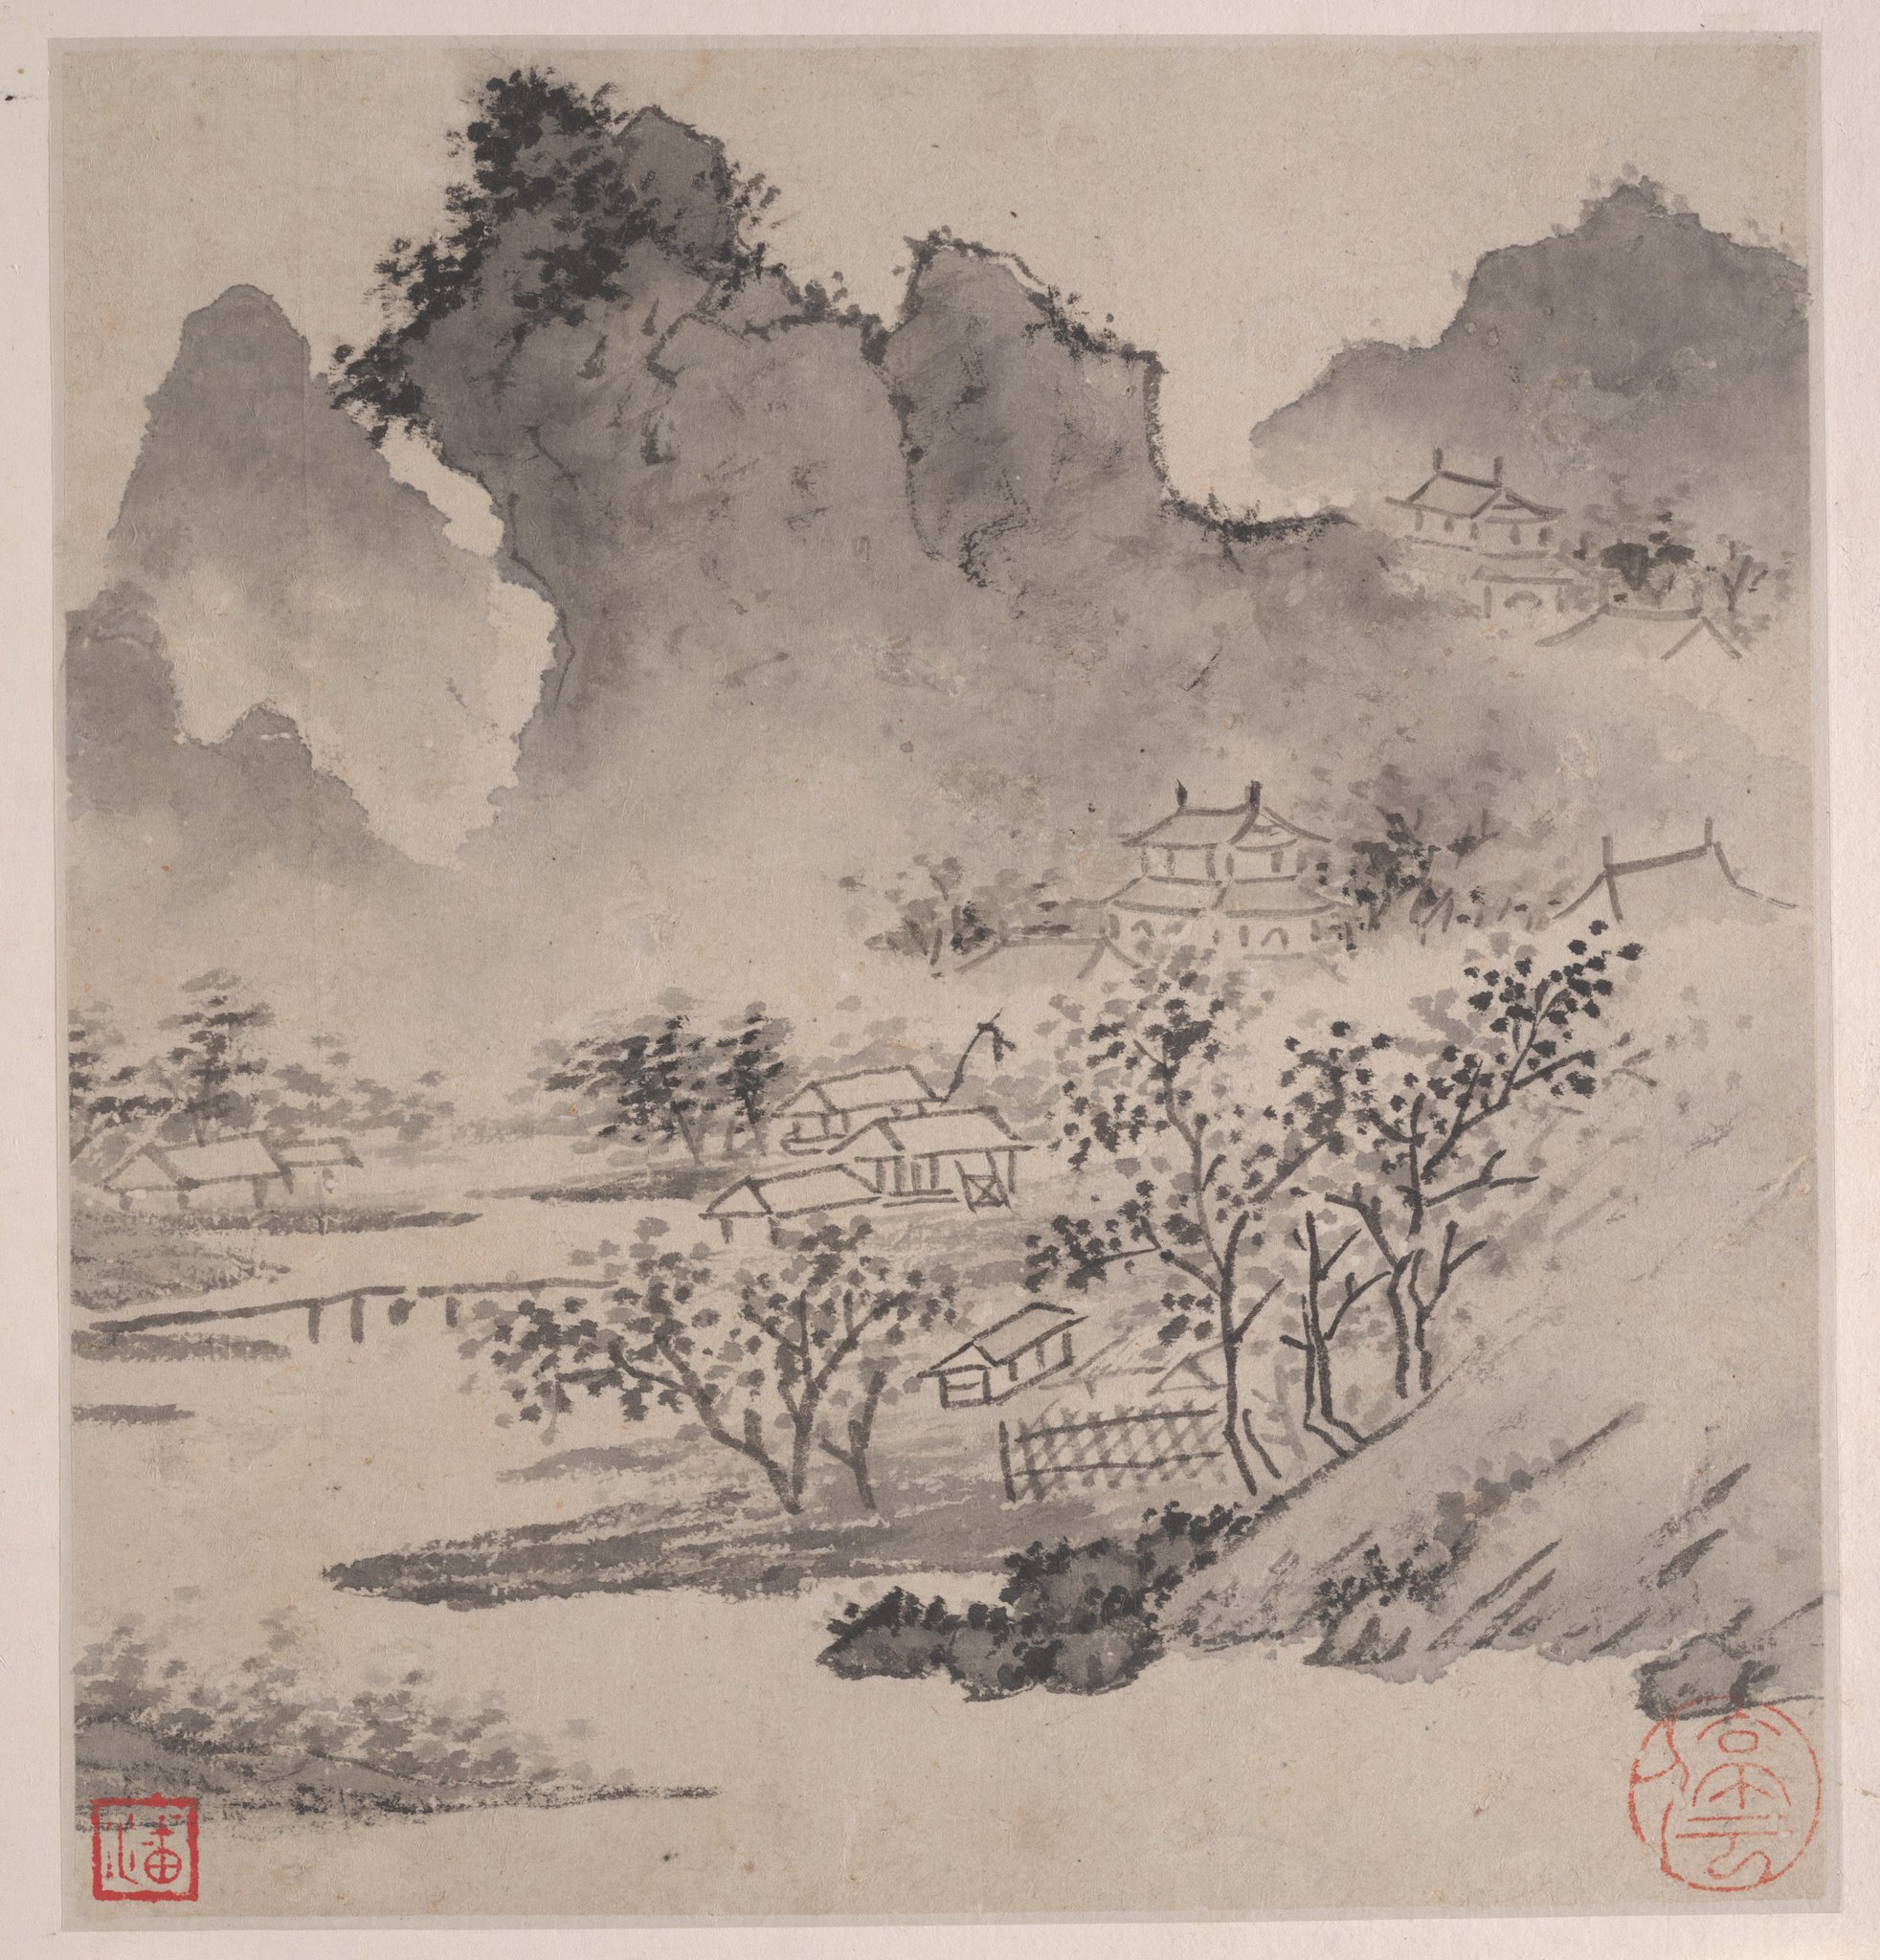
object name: album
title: Eight Songs of the Xiao and Xiang Rivers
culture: chinese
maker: unidentified artist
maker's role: artist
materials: ink, paper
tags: poetry,landscapes